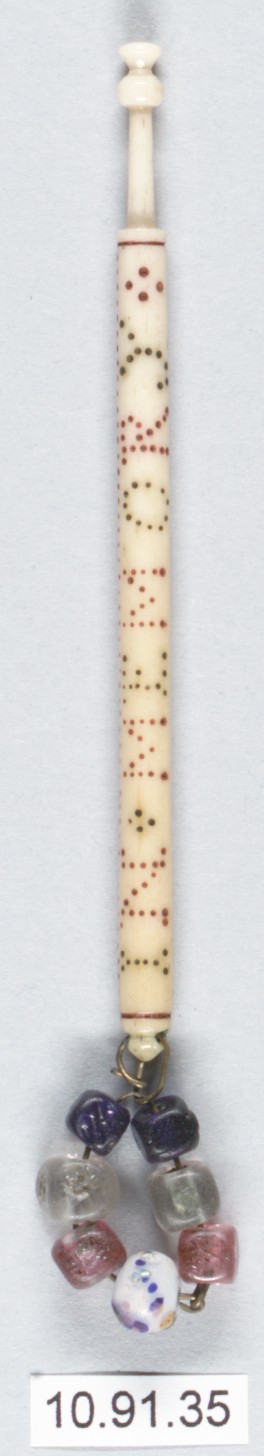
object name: bobbin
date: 1801-1900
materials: bone